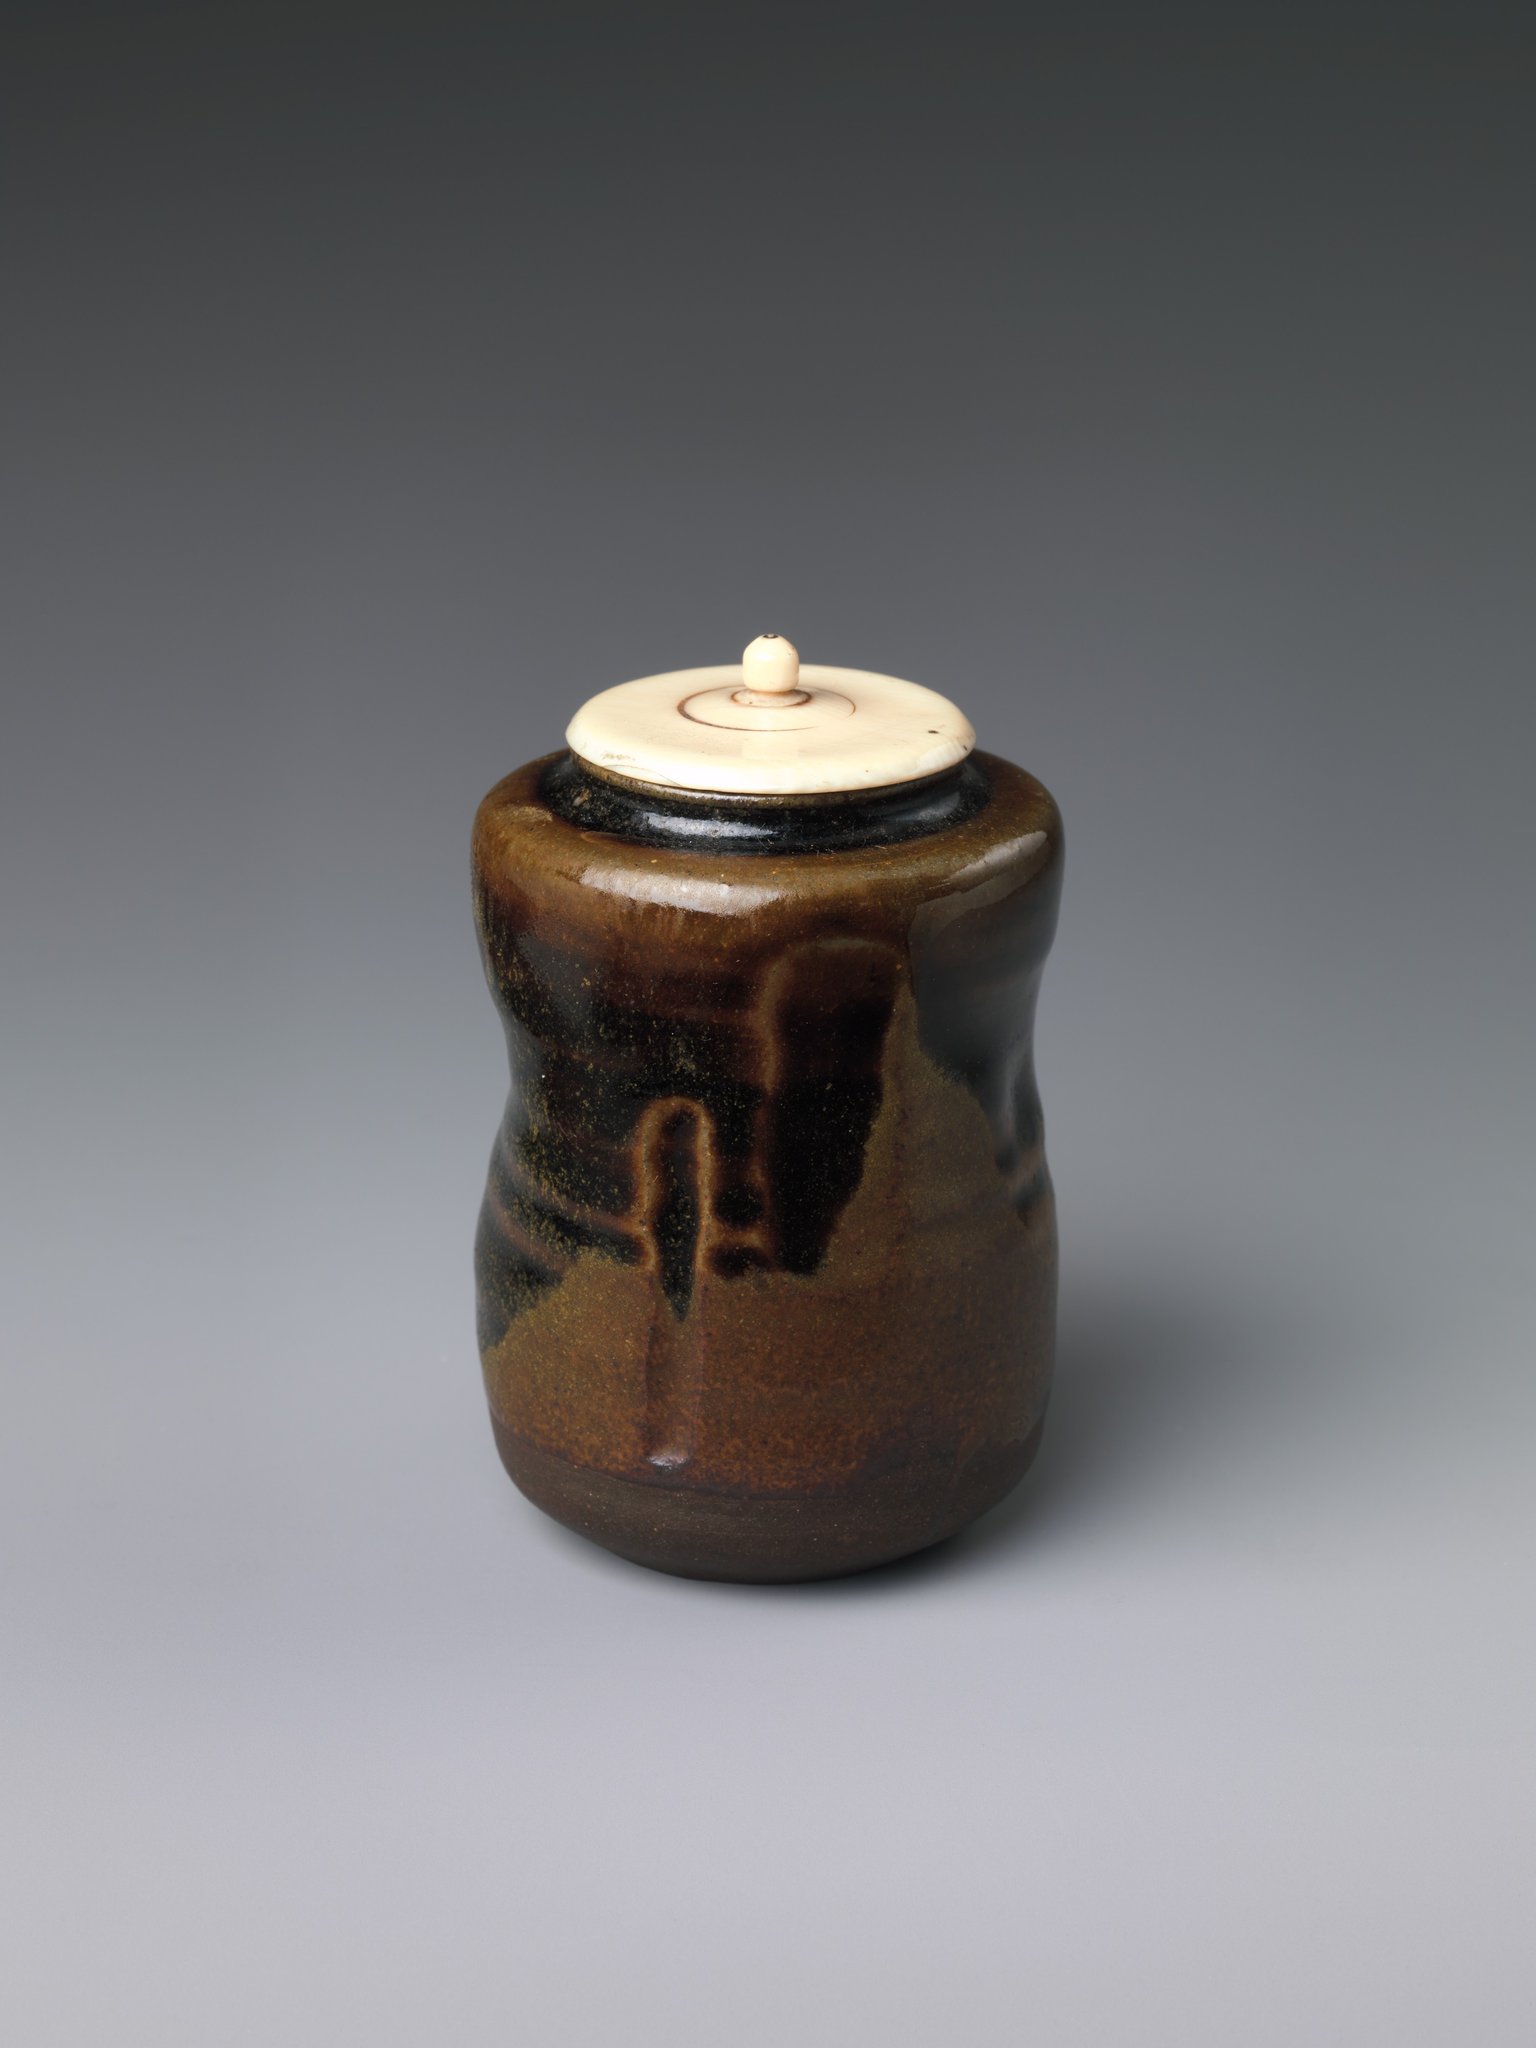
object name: tea caddy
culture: japanese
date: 1601-1700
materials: glaze, iron, stoneware